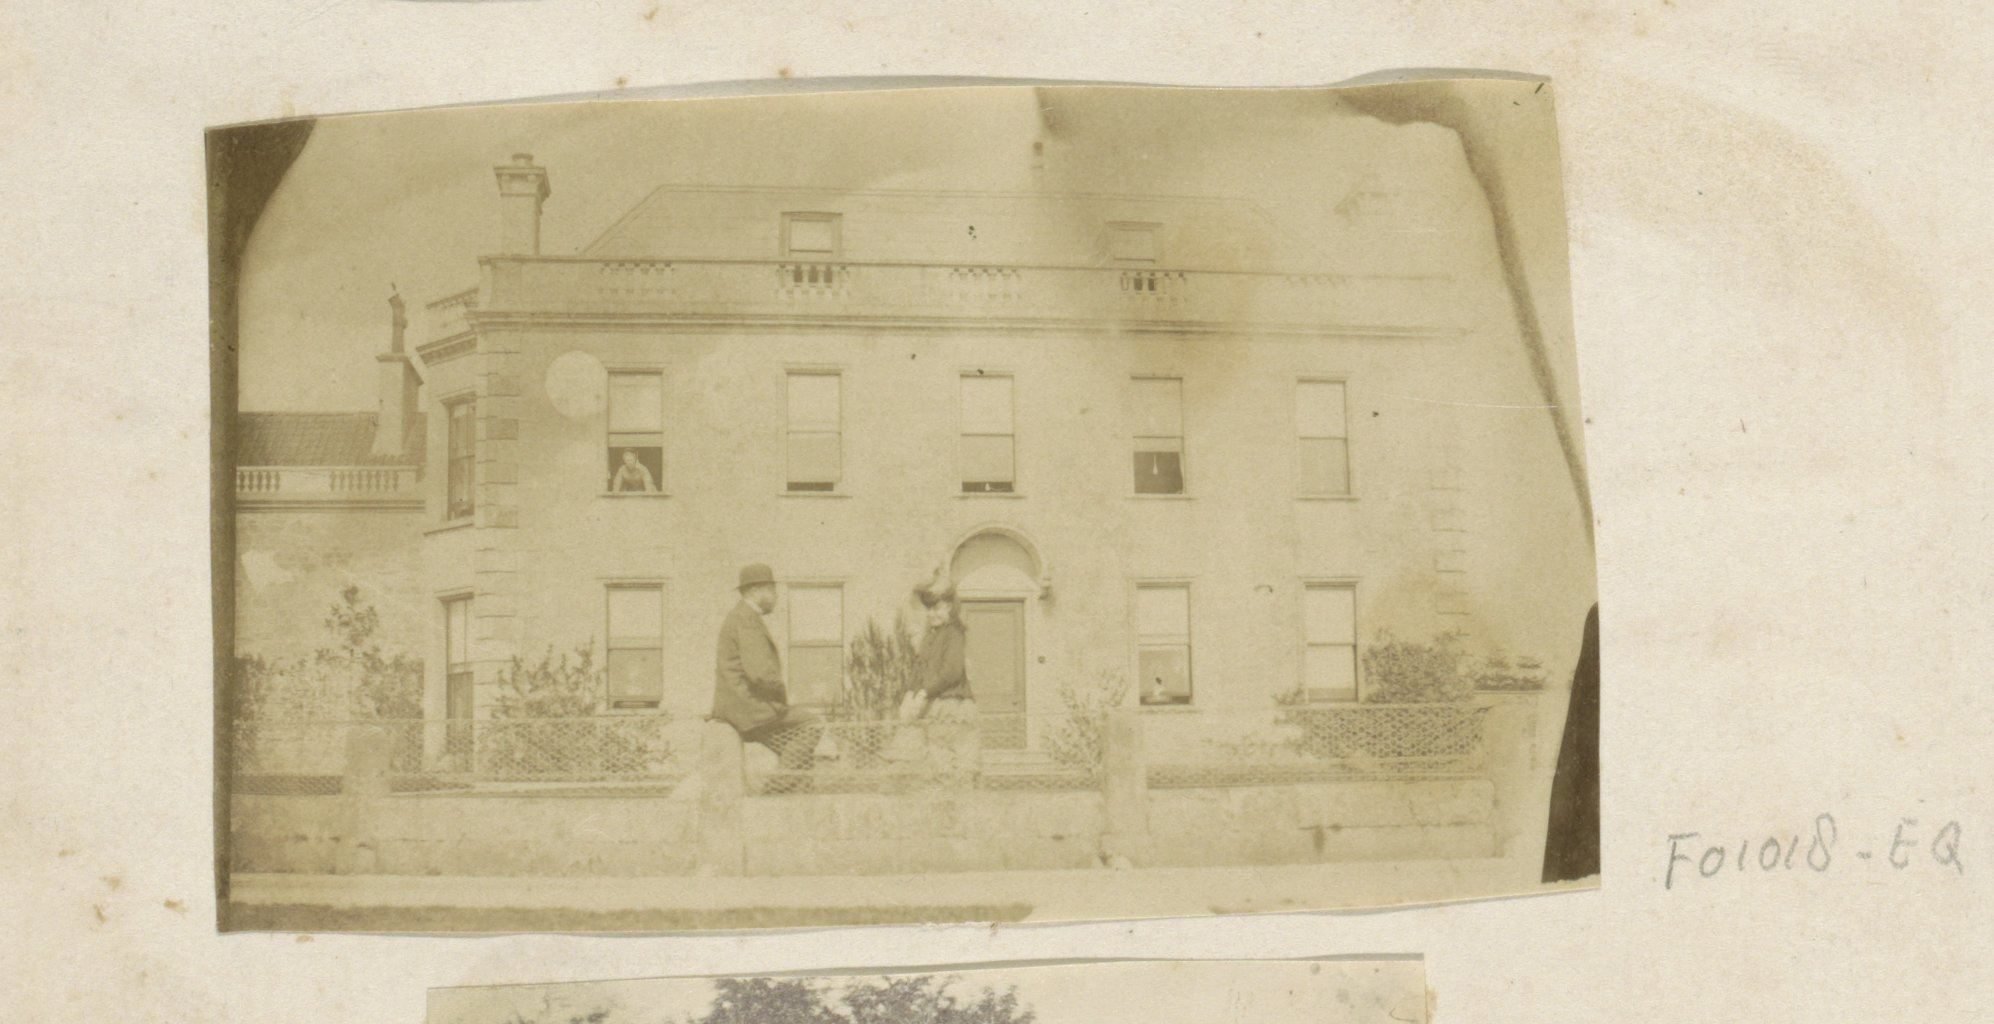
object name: photograph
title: Man en en een meisje zittend op een hek voor een landhuis, vermoedelijk in Whatley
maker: Anonymous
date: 1860-1870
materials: paper, photographic support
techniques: albumen print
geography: whatley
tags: adolescent, young woman, maiden, fence, wall, paling, adult man, villa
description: Onderdeel van Engels familiealbum met foto's van personen, reizen, cricket en kunstwerken.